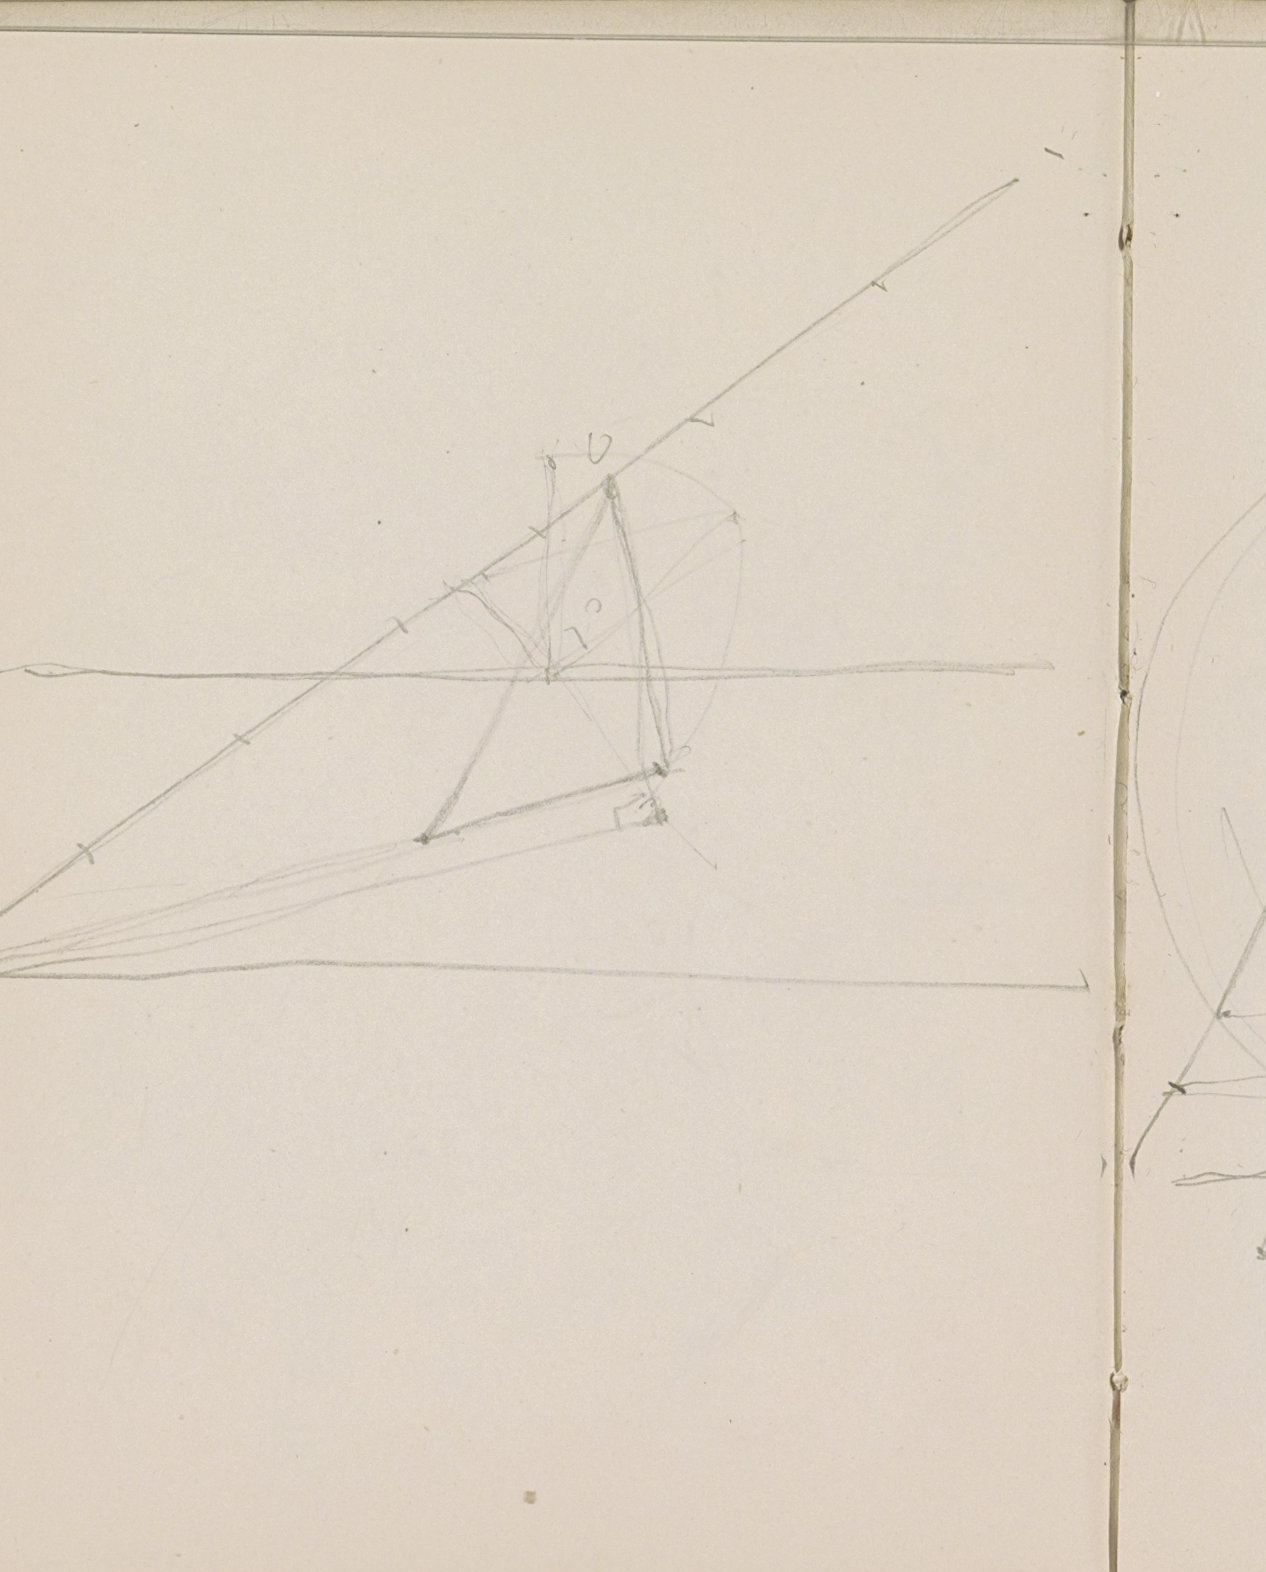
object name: sketchbook leaf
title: Meetkundige grafiek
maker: reijer stolk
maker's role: draughtsman, print maker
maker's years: 1896-1945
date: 1916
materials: paper, pencil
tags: mathematics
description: Blad 49 verso uit een schetsboek met 72 bladen.